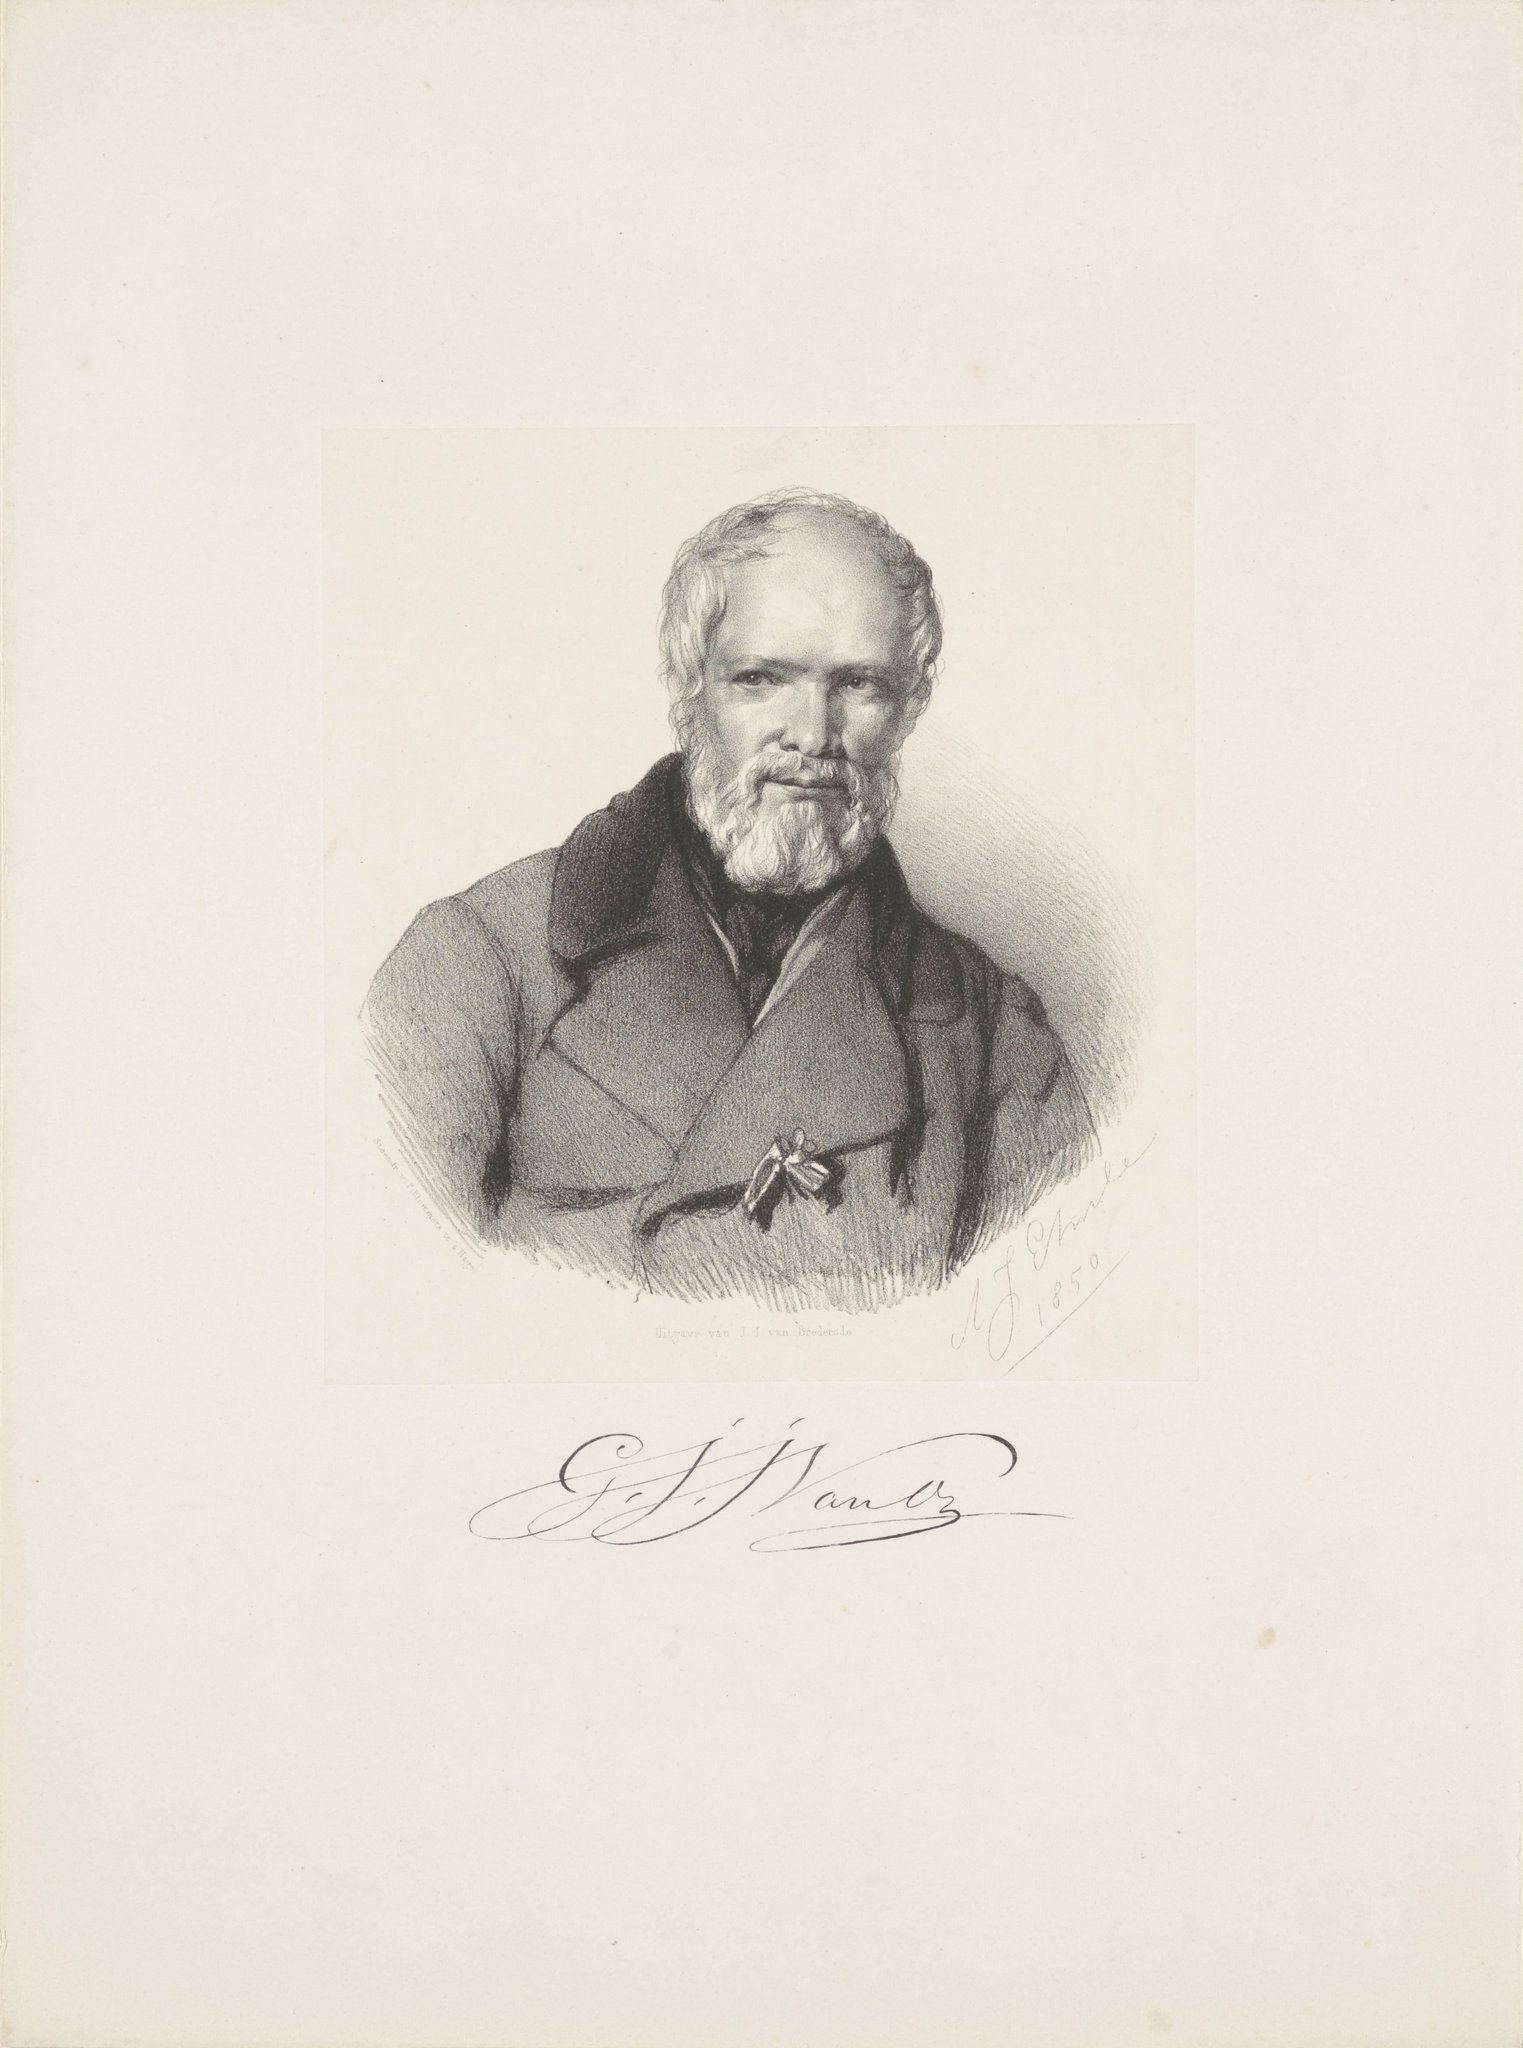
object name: print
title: Portret van Georgius Jacobus Johannes van Os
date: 1847-1853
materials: paper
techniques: lithograph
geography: the hague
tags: the hague, paris, painter, print maker, draughtsman, georgius jacobus johannes van os, historical persons (+ (full) bust portrait)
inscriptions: collector's mark: Lugt 2228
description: De geportretteerde kijkt naar links en draagt een lintje aan zijn jas. Onder het portret zijn signatuur.